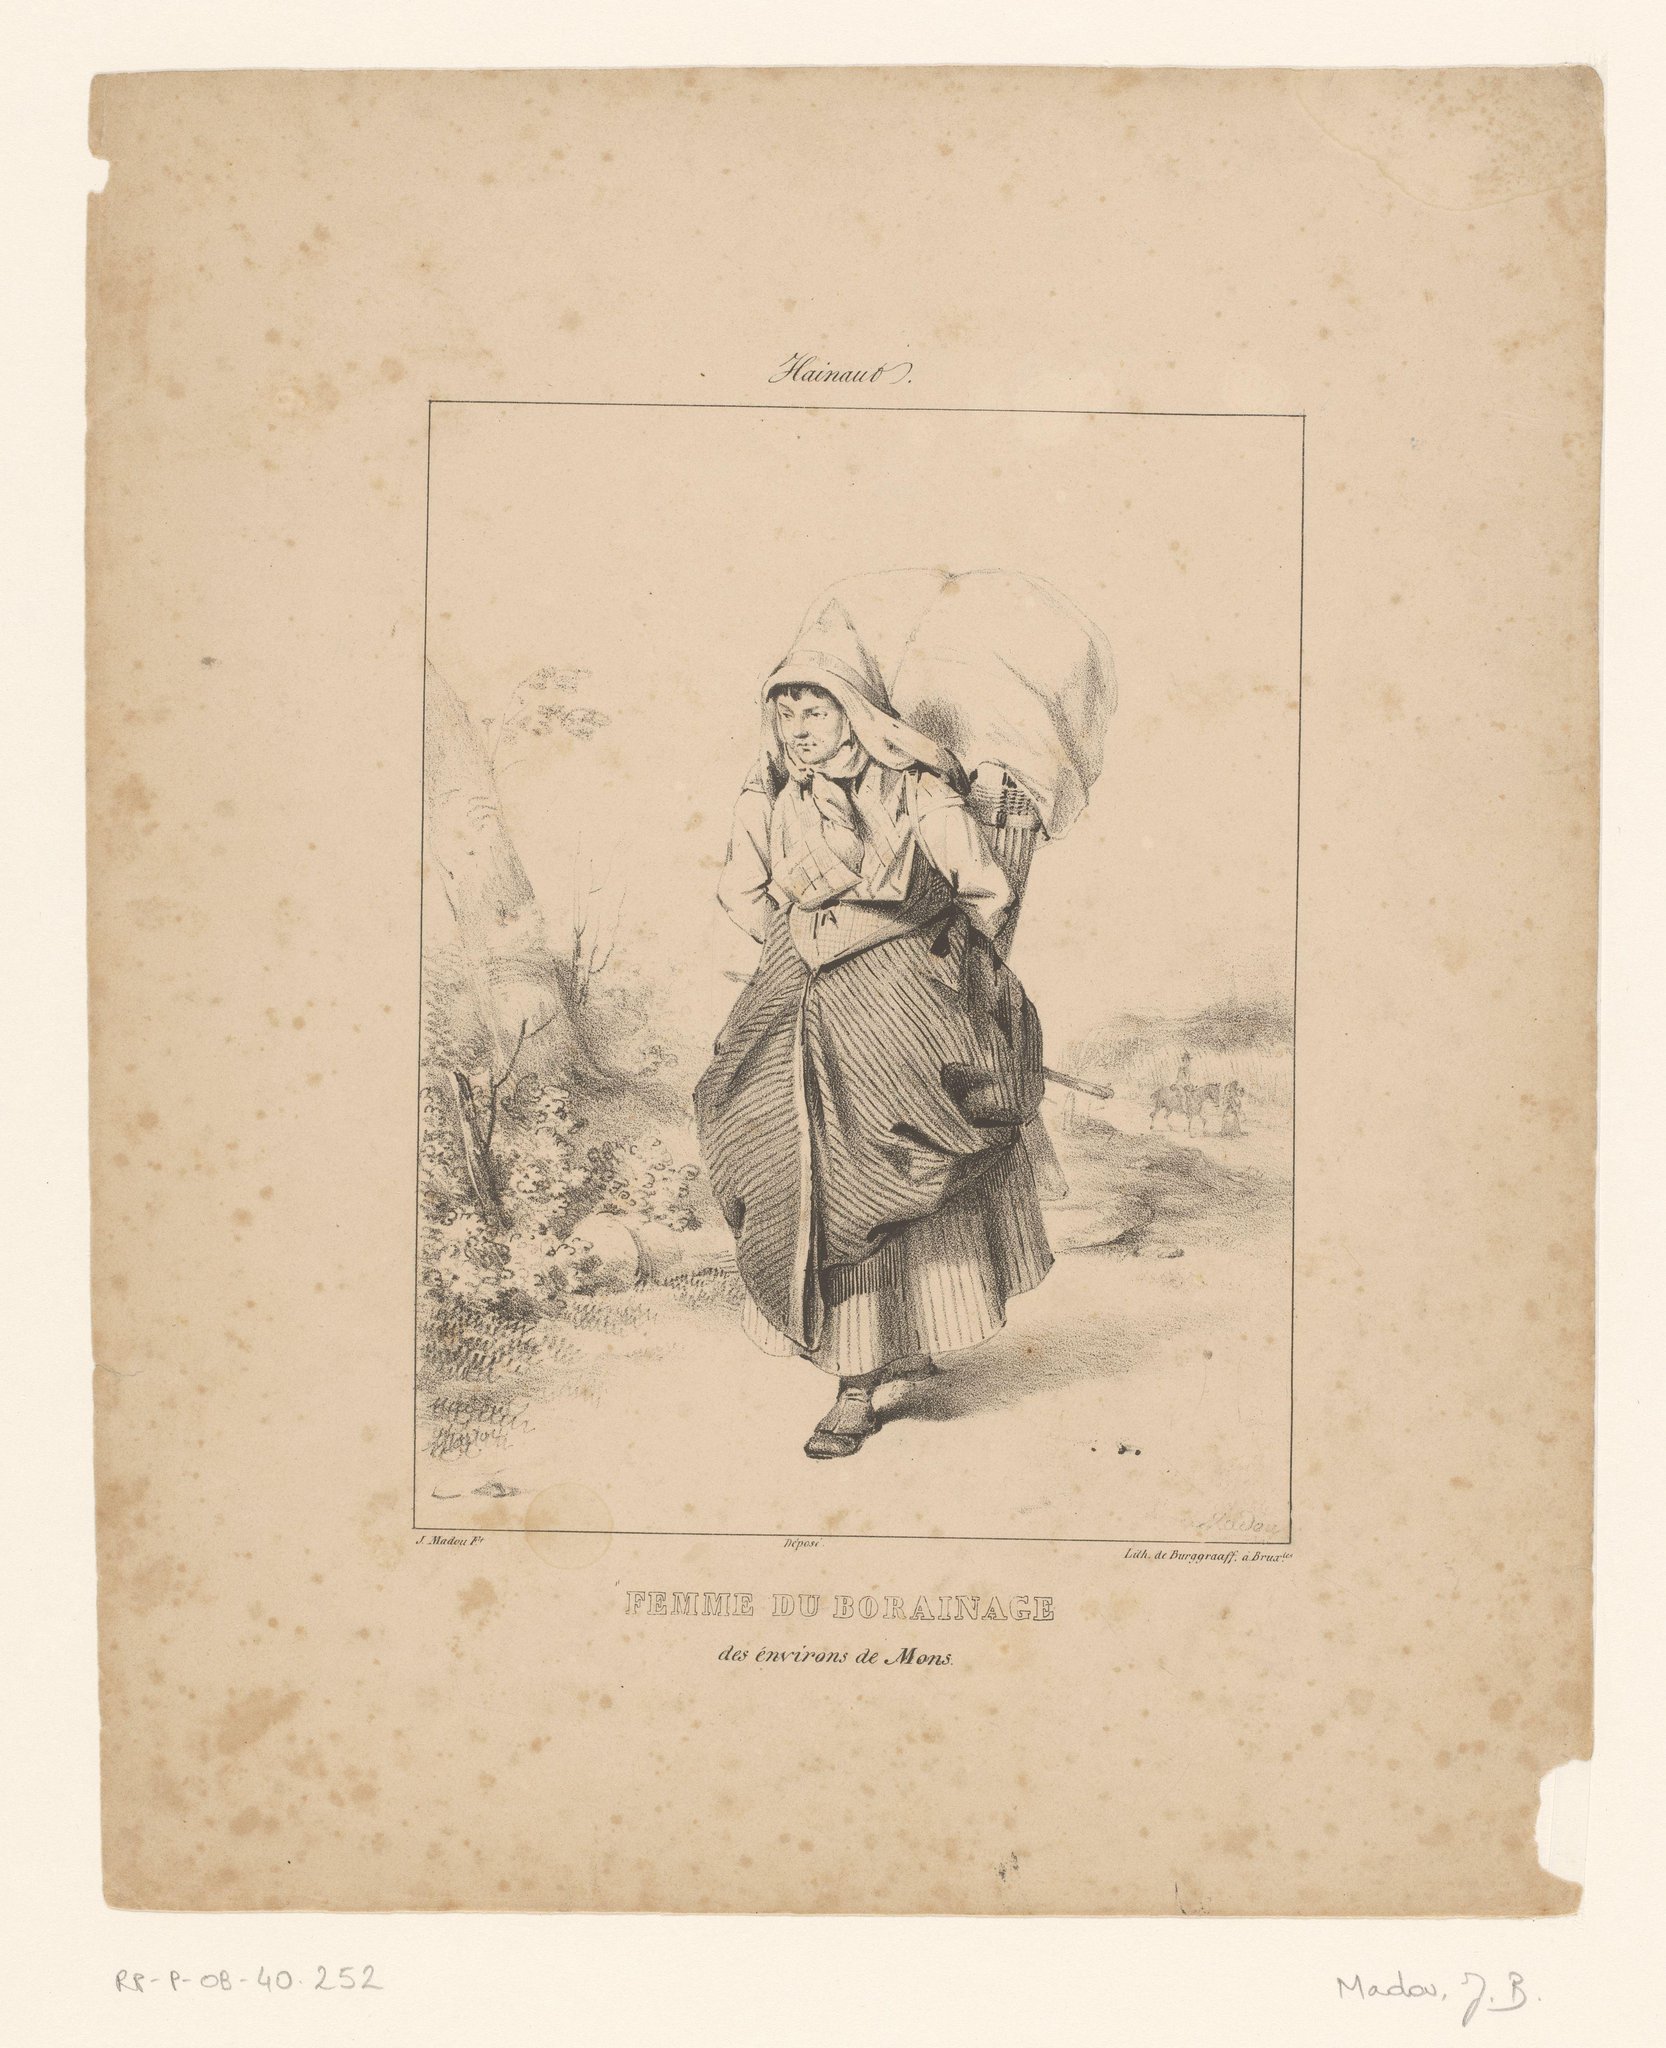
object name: print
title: Vrouw uit Borinage draagt een mand op haar rug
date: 1825-1835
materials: paper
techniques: lithograph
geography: brussels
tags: adult woman, carrying something in basket, bag, rucksack, etc., folk costume, regional costume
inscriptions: : ‘Déposé’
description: Van den Burggraaff wilde een serie (twintig afleveringen met telkens vier platen) uitgeven met kostuums uit alle provincies van Nederland en België onder de titel 'Costumes du peuple de toutes les provinces des Pays-Bas'. Hij begint met deze serie in 1825 en eindigt hiermee bij de dertiende aflevering in 1830. Omdat in 1830 België zicht afsplitst van Nederland geeft hij de prenten daarna apart uit onder de titels 'Costumes de peuple Hollandais' en 'Collection de costumes du peuple des provinces de la Belgique' (1835).